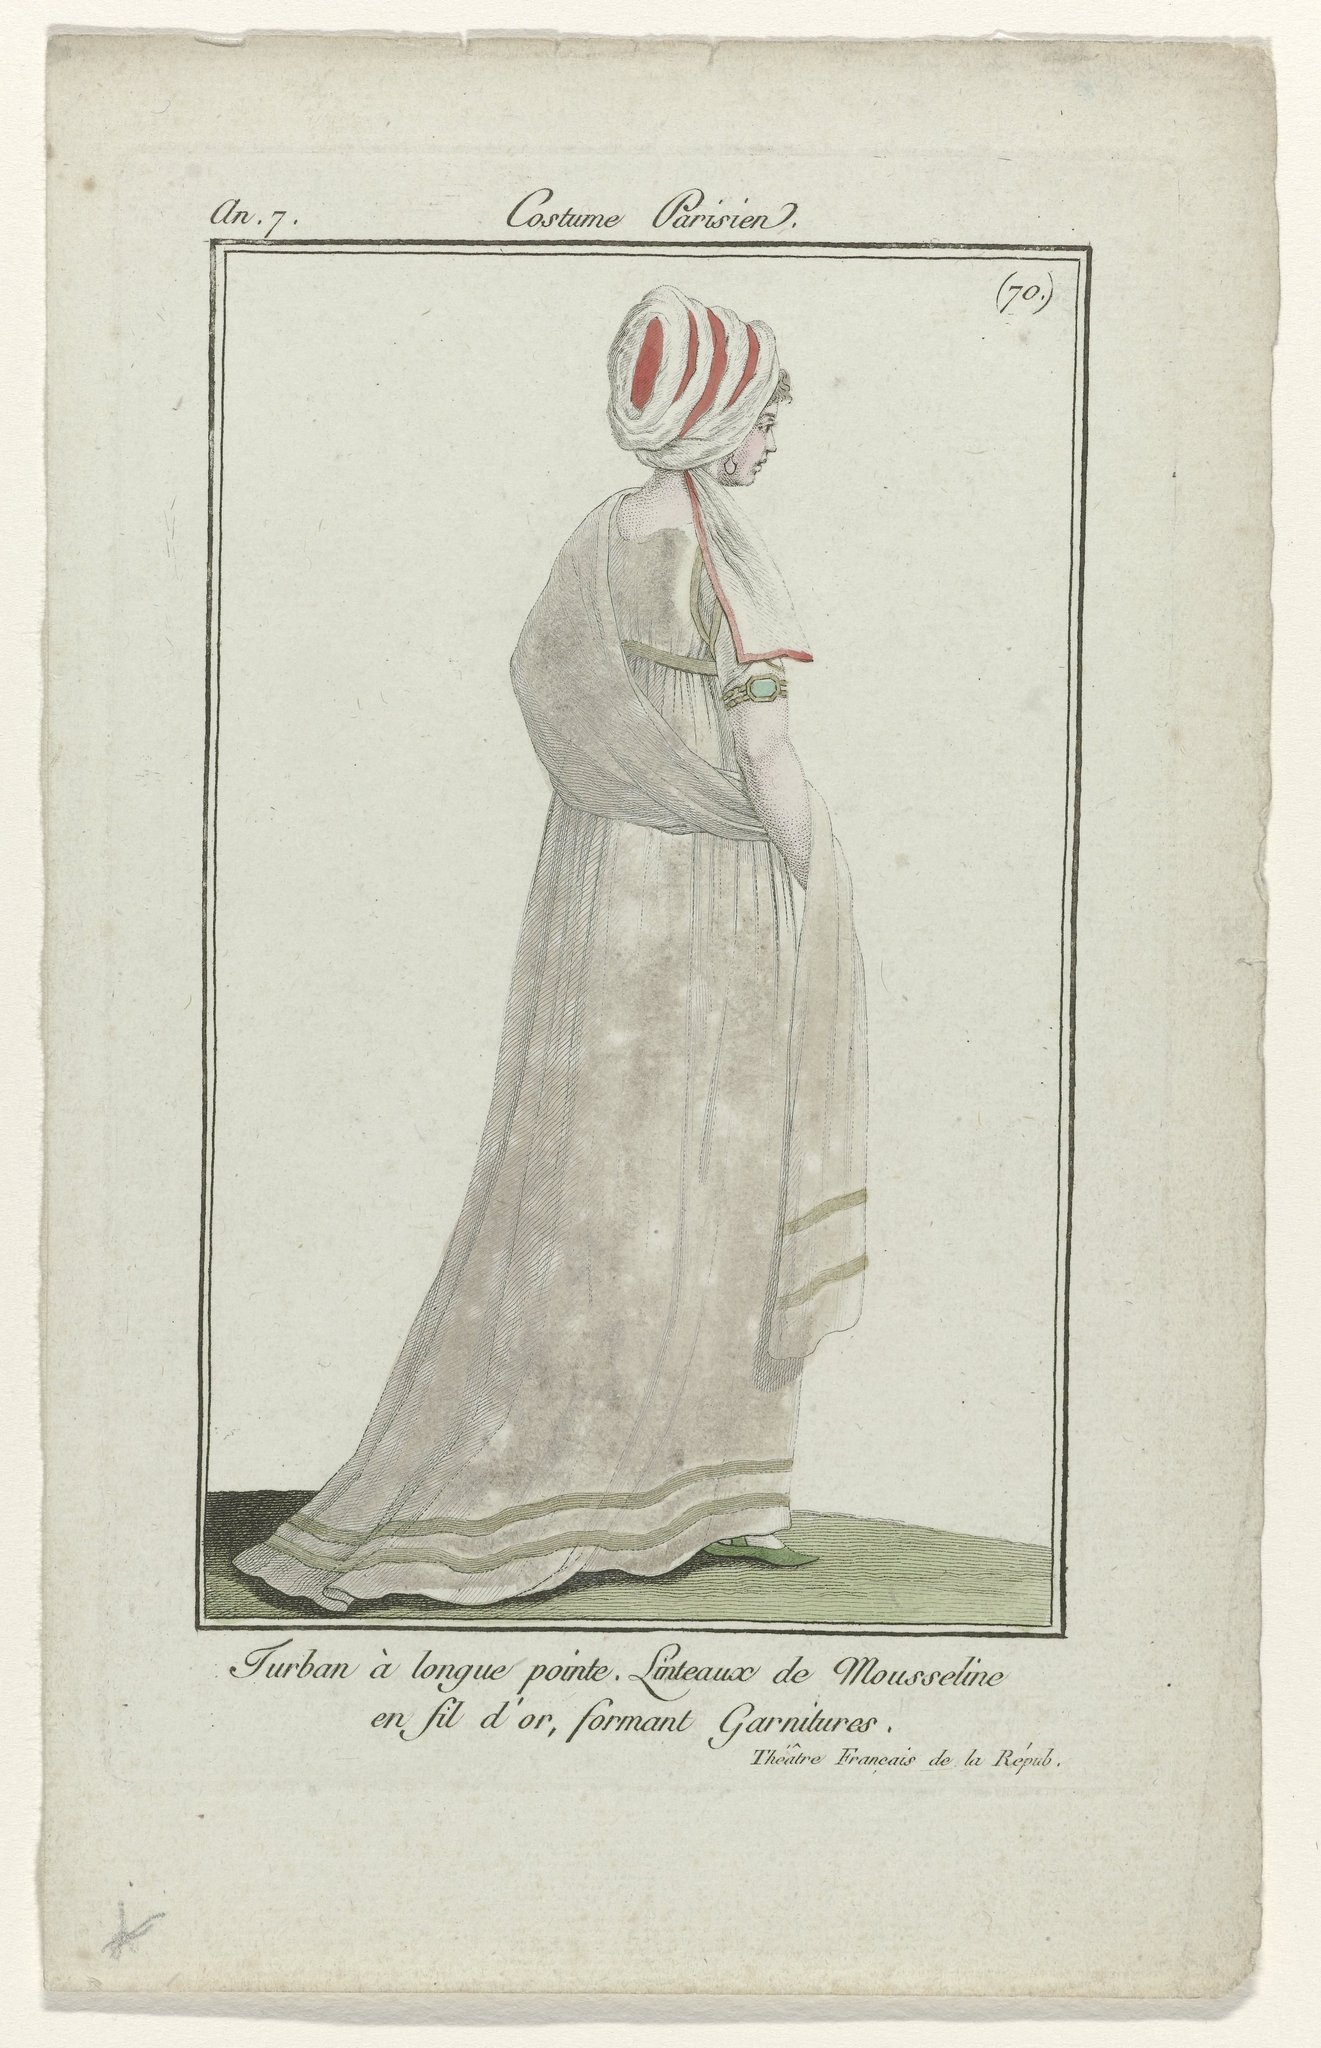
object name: fashion print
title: Journal des Dames et des Modes, Costume Parisien, 27 octobre 1798, An 7 (70) : Turban à longue point (...)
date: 1798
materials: paper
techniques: engraving, hand coloring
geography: paris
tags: ear-rings (+ women's clothes), head-gear: turban (+ women's clothes), fashion plates, shoes, sandals (+ women's clothes), dress, gown (+ women's clothes), bracelet, wristlet (+ women's clothes)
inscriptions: caption: ‘Turban à longue pointe. Linteaux de Mousseline en fil d'or, formant Garnitures. / Théâtre Français de la Répub.’, title: ‘Costume Parisien.’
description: Tulband met een lange afhangende punt. Japon met sleep en een lange sjaal, beide afgezet met gestreepte banden van mousseline en gouddraad. Accessoires: oorbel in het rechteroor, armband om de rechter bovenarm, platte schoen met puntige neus. Volgens het onderschrift is dit kostuum naar het leven getekend bij 'Théâtre Français de la Répub.'. De prent maakt deel uit van het modetijdschrift Journal des Dames et des Modes, uitgegeven door Sellèque, Parijs, 1797-1839.